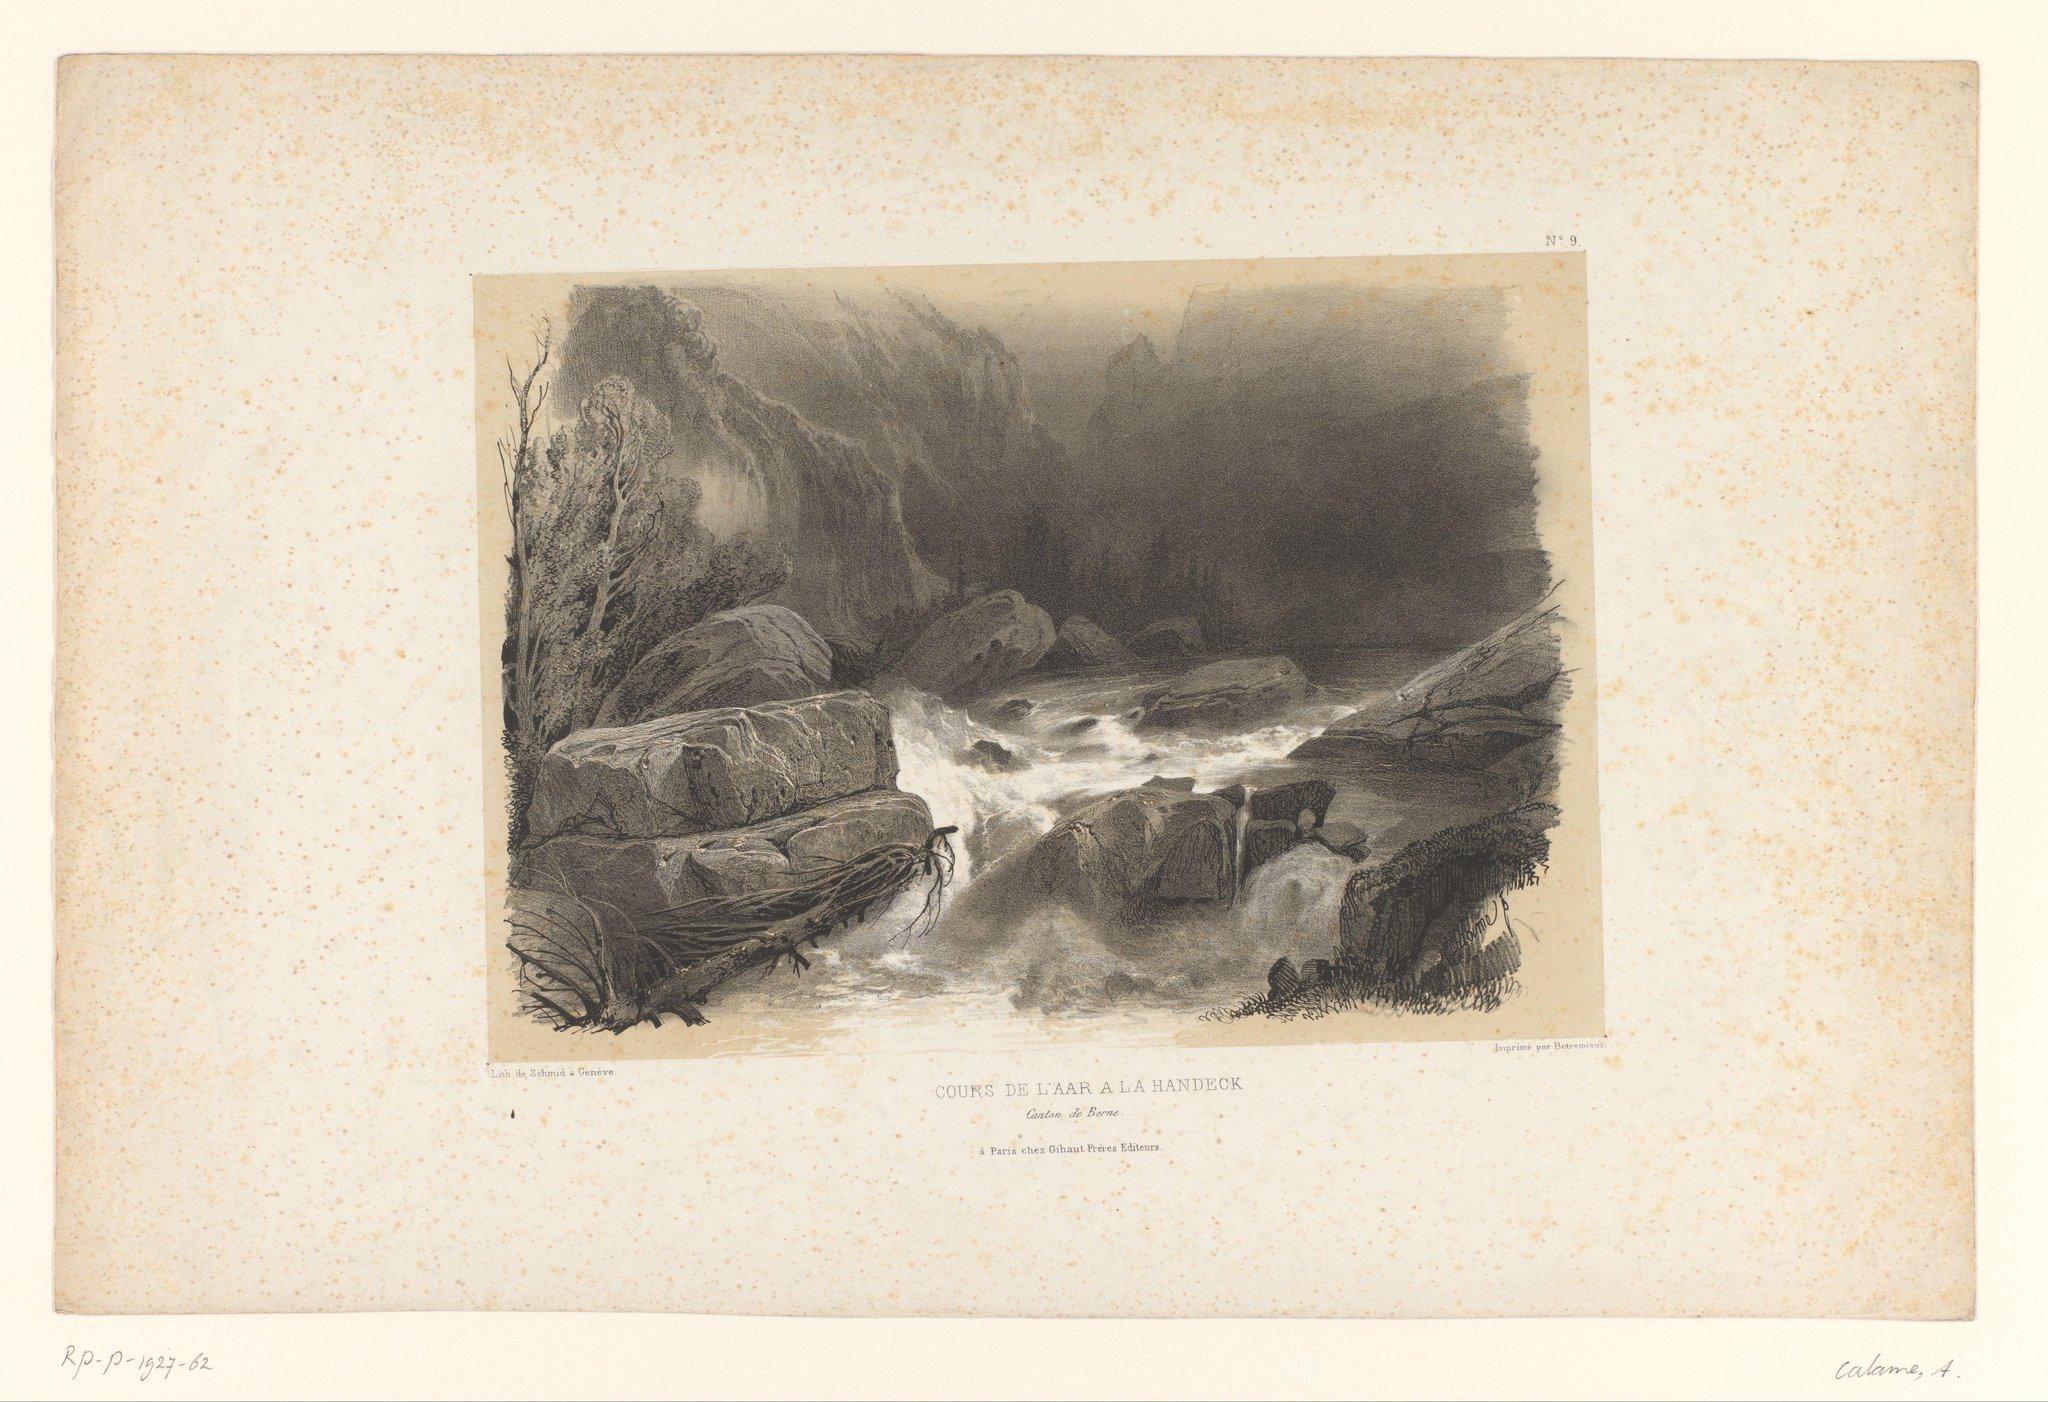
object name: print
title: Cours de l'Aar à la Handeck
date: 1842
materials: paper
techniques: tone lithography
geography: paris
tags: brook, mountains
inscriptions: collector's mark: Lugt 2166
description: Prent gepubliceerd in: 'Douze vues des Vallées de Lauterbrunnen et Meyringen, dessinées d'après nature et lithographiées par A. Calame', 2e cahier, Genève 1842 (uitgever: J.H. Wessel).